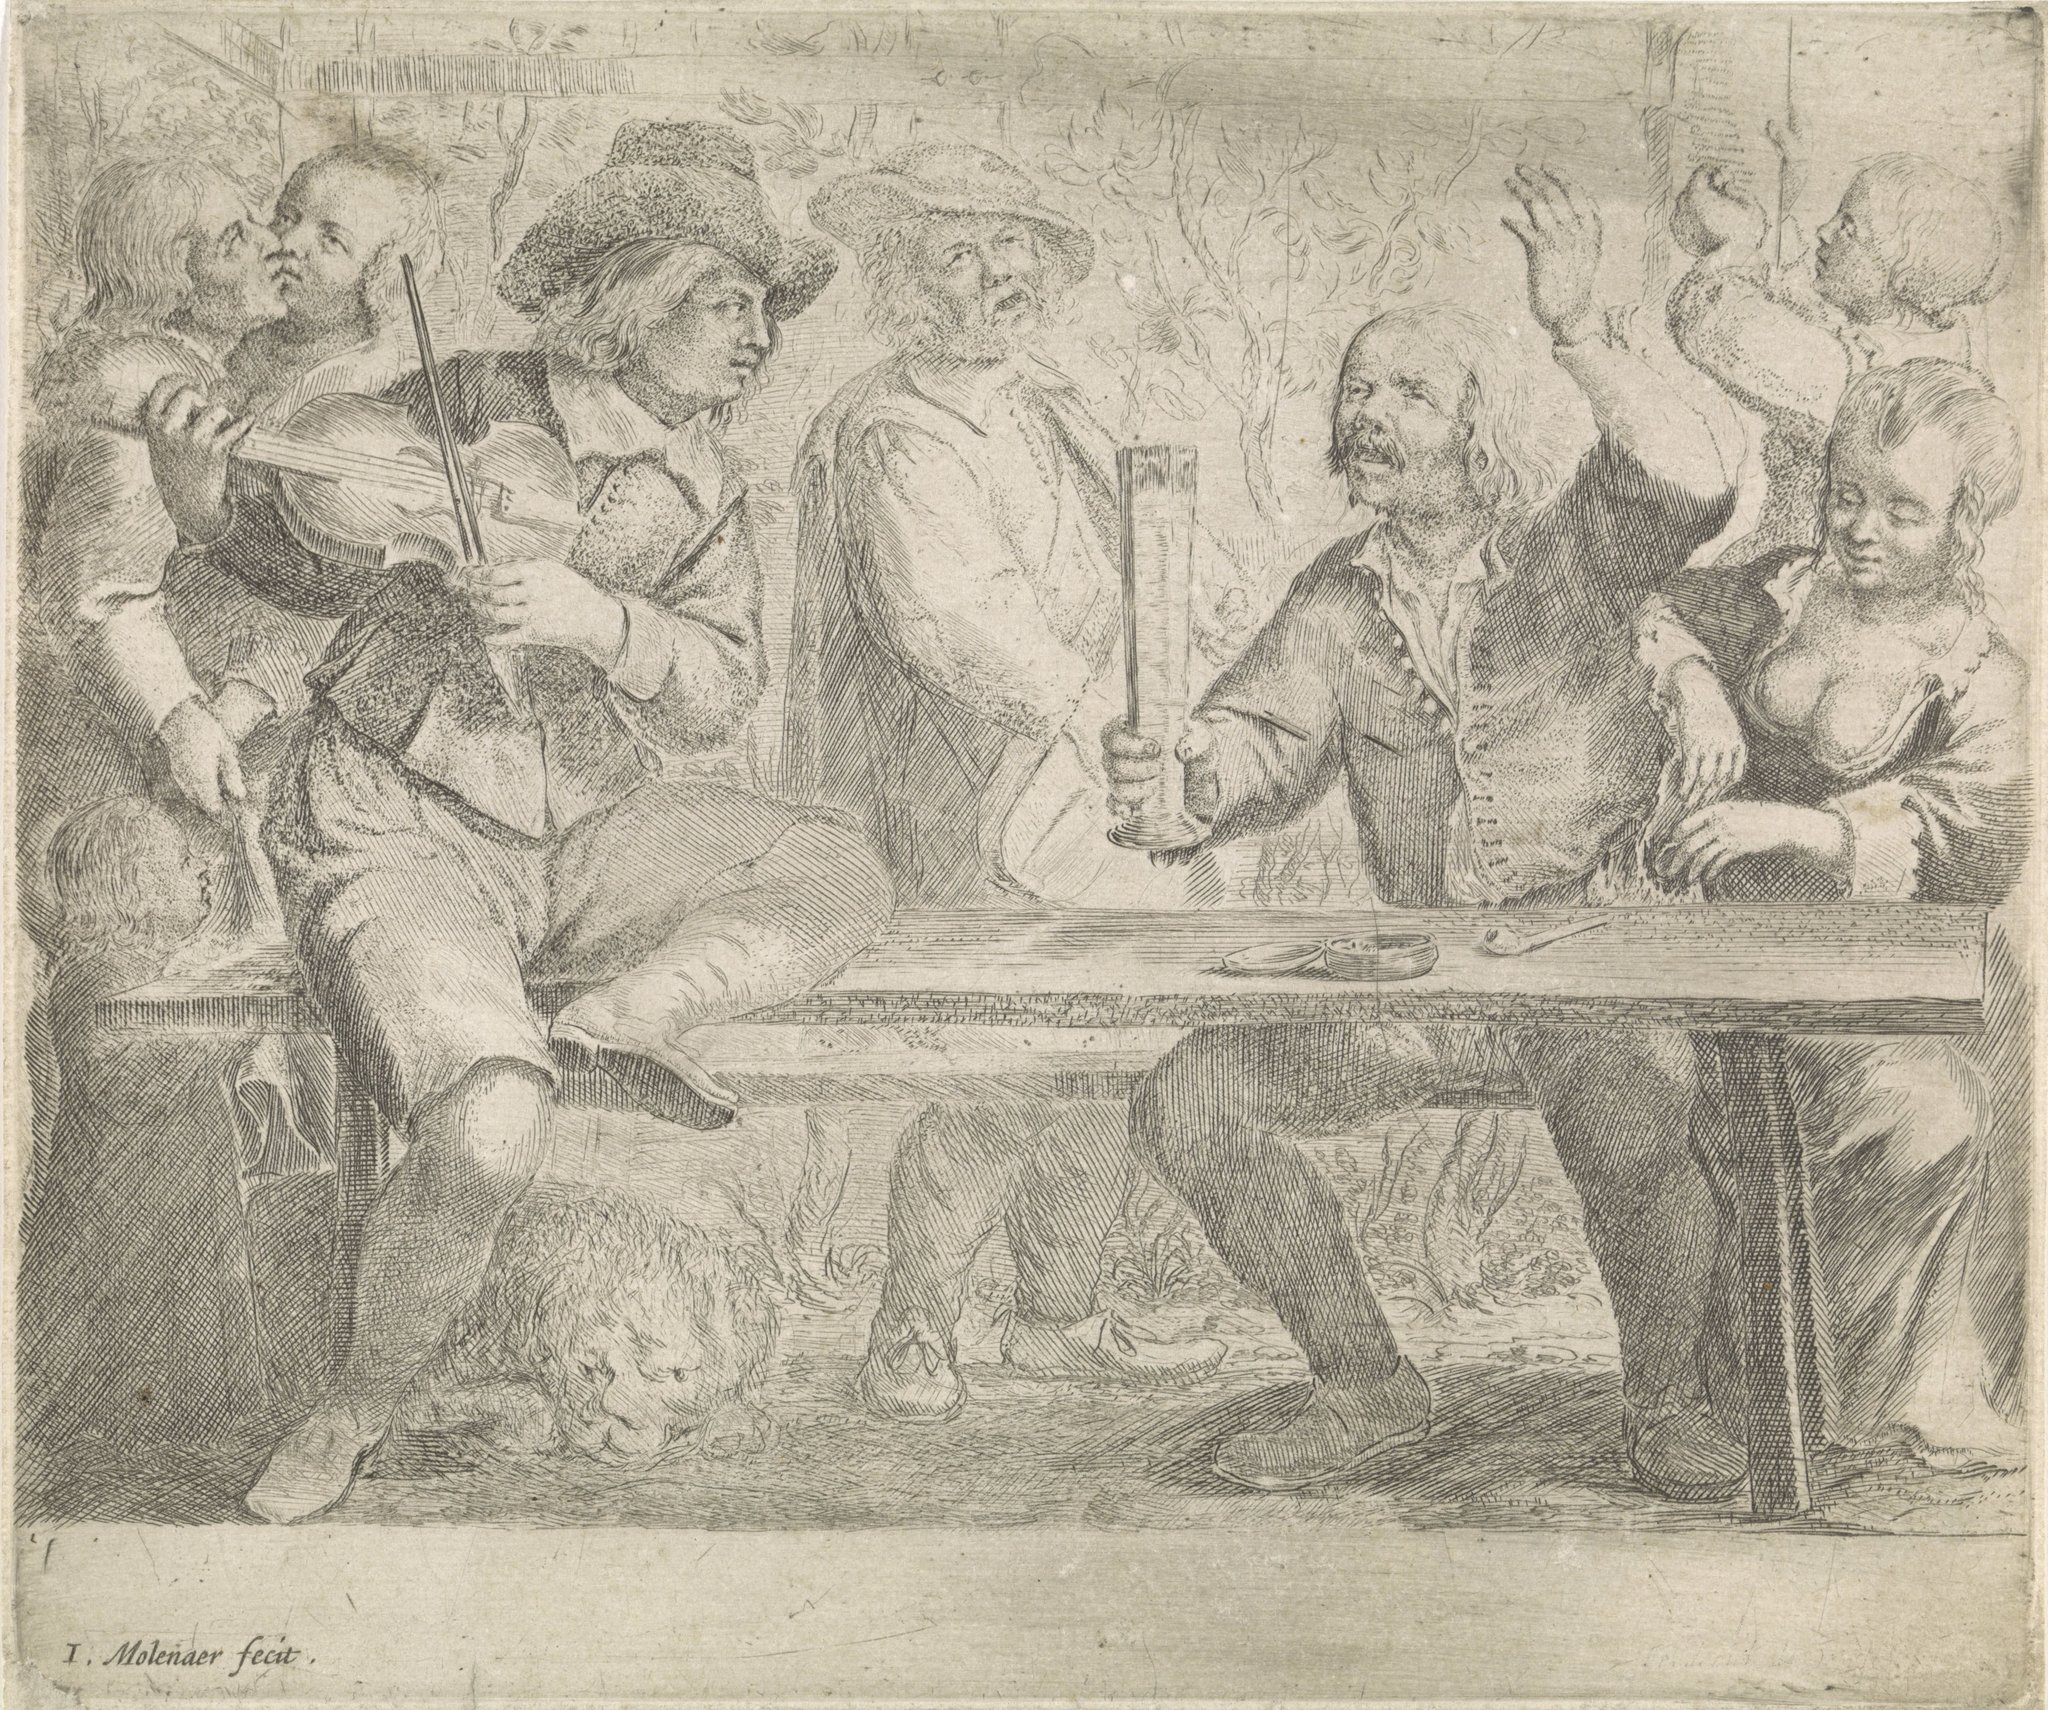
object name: print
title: Muzikanten en drinker in een herberg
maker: jan miense molenaer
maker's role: draughtsman, painter, print maker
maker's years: 1609-1668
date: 1619-1708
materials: paper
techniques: engraving, etching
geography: amsterdam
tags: (lovers) kissing each other, hurdy-gurdy player, glass, rummer, the man is robbed (brothel scene), dog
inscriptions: collector's mark: Lugt 2228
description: In een herberg of bordeel zit een man achter een tafel met een glas in zijn hand. Hij wordt beroofd door een prostituee. Bij de tafel twee muzikanten, waarvan de een met een viool en de ander zingend met een draailier in de handen. Links een minnekozend paar en een kind. Rechtsachter houdt een vrouw de genuttigde consumpties bij. Onder de tafel een hond.